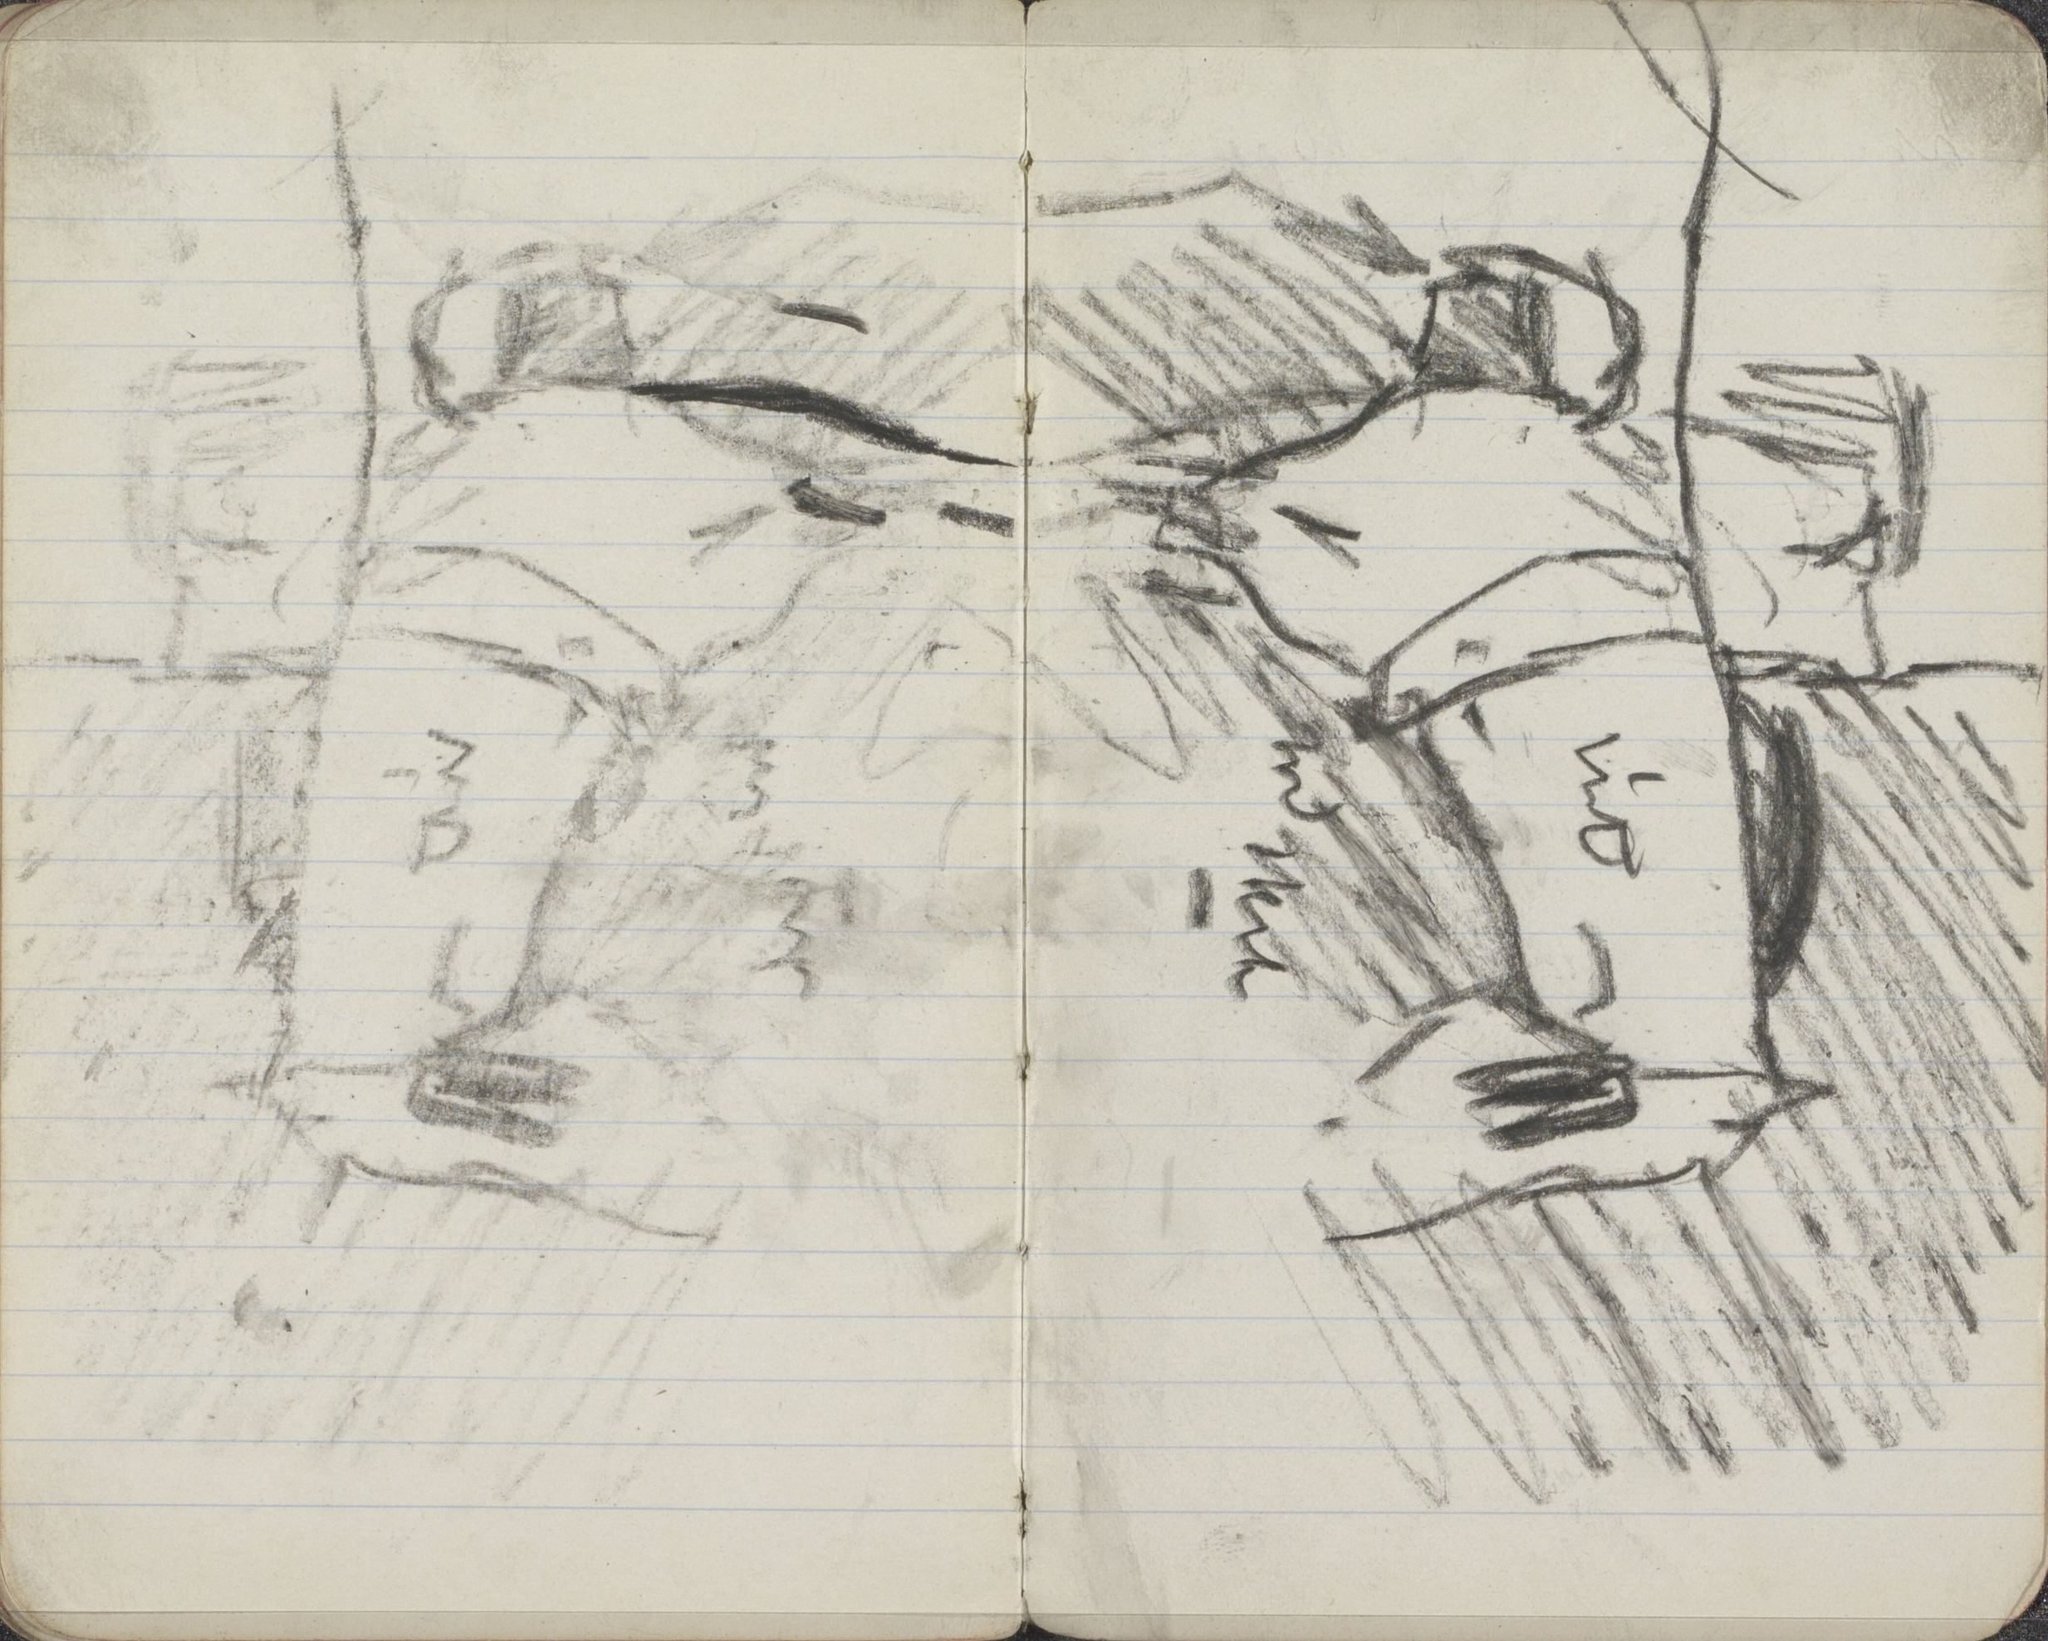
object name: sketchbook leaf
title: Figuur bij een aangespannen paard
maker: george hendrik breitner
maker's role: draughtsman, painter, print maker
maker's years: 1857-1923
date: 1890-1900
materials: chalk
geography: amsterdam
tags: adult man, horse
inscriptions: kleurnotitie, handgeschreven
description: Pagina 65 en pagina 66 uit een schetsboek met 33 bladen.